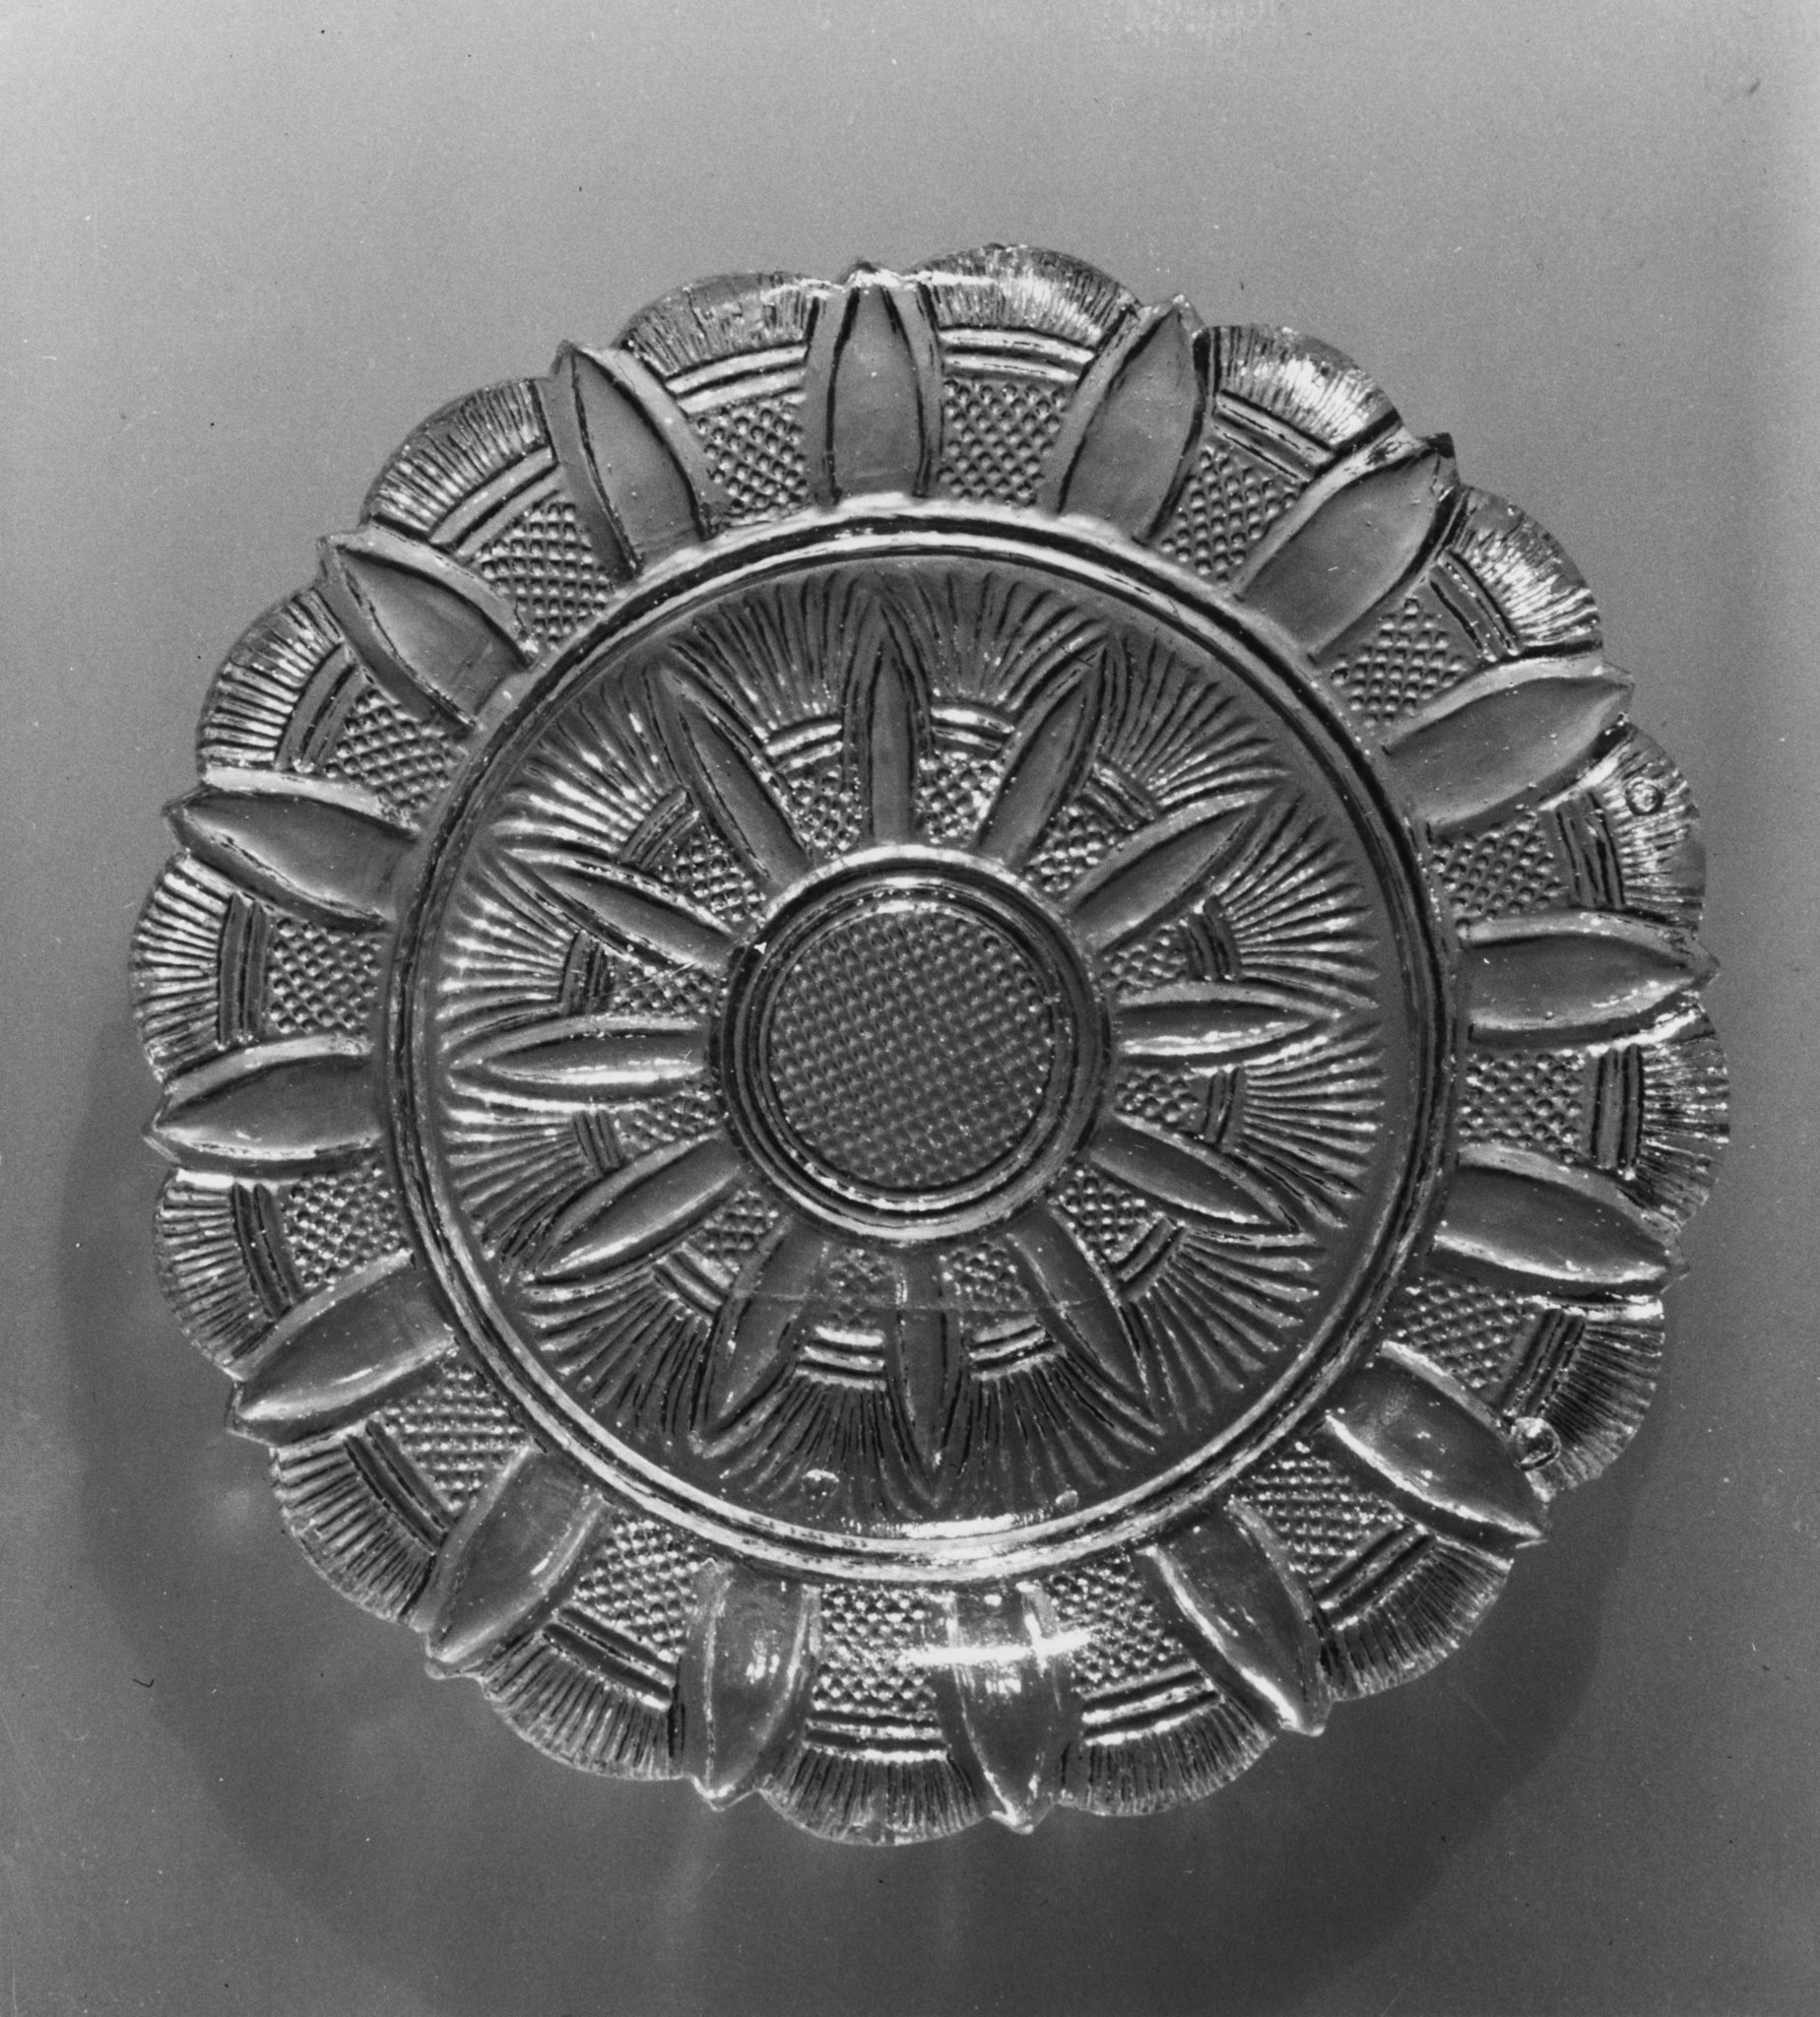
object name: plate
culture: american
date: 1830-1850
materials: glass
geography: united states